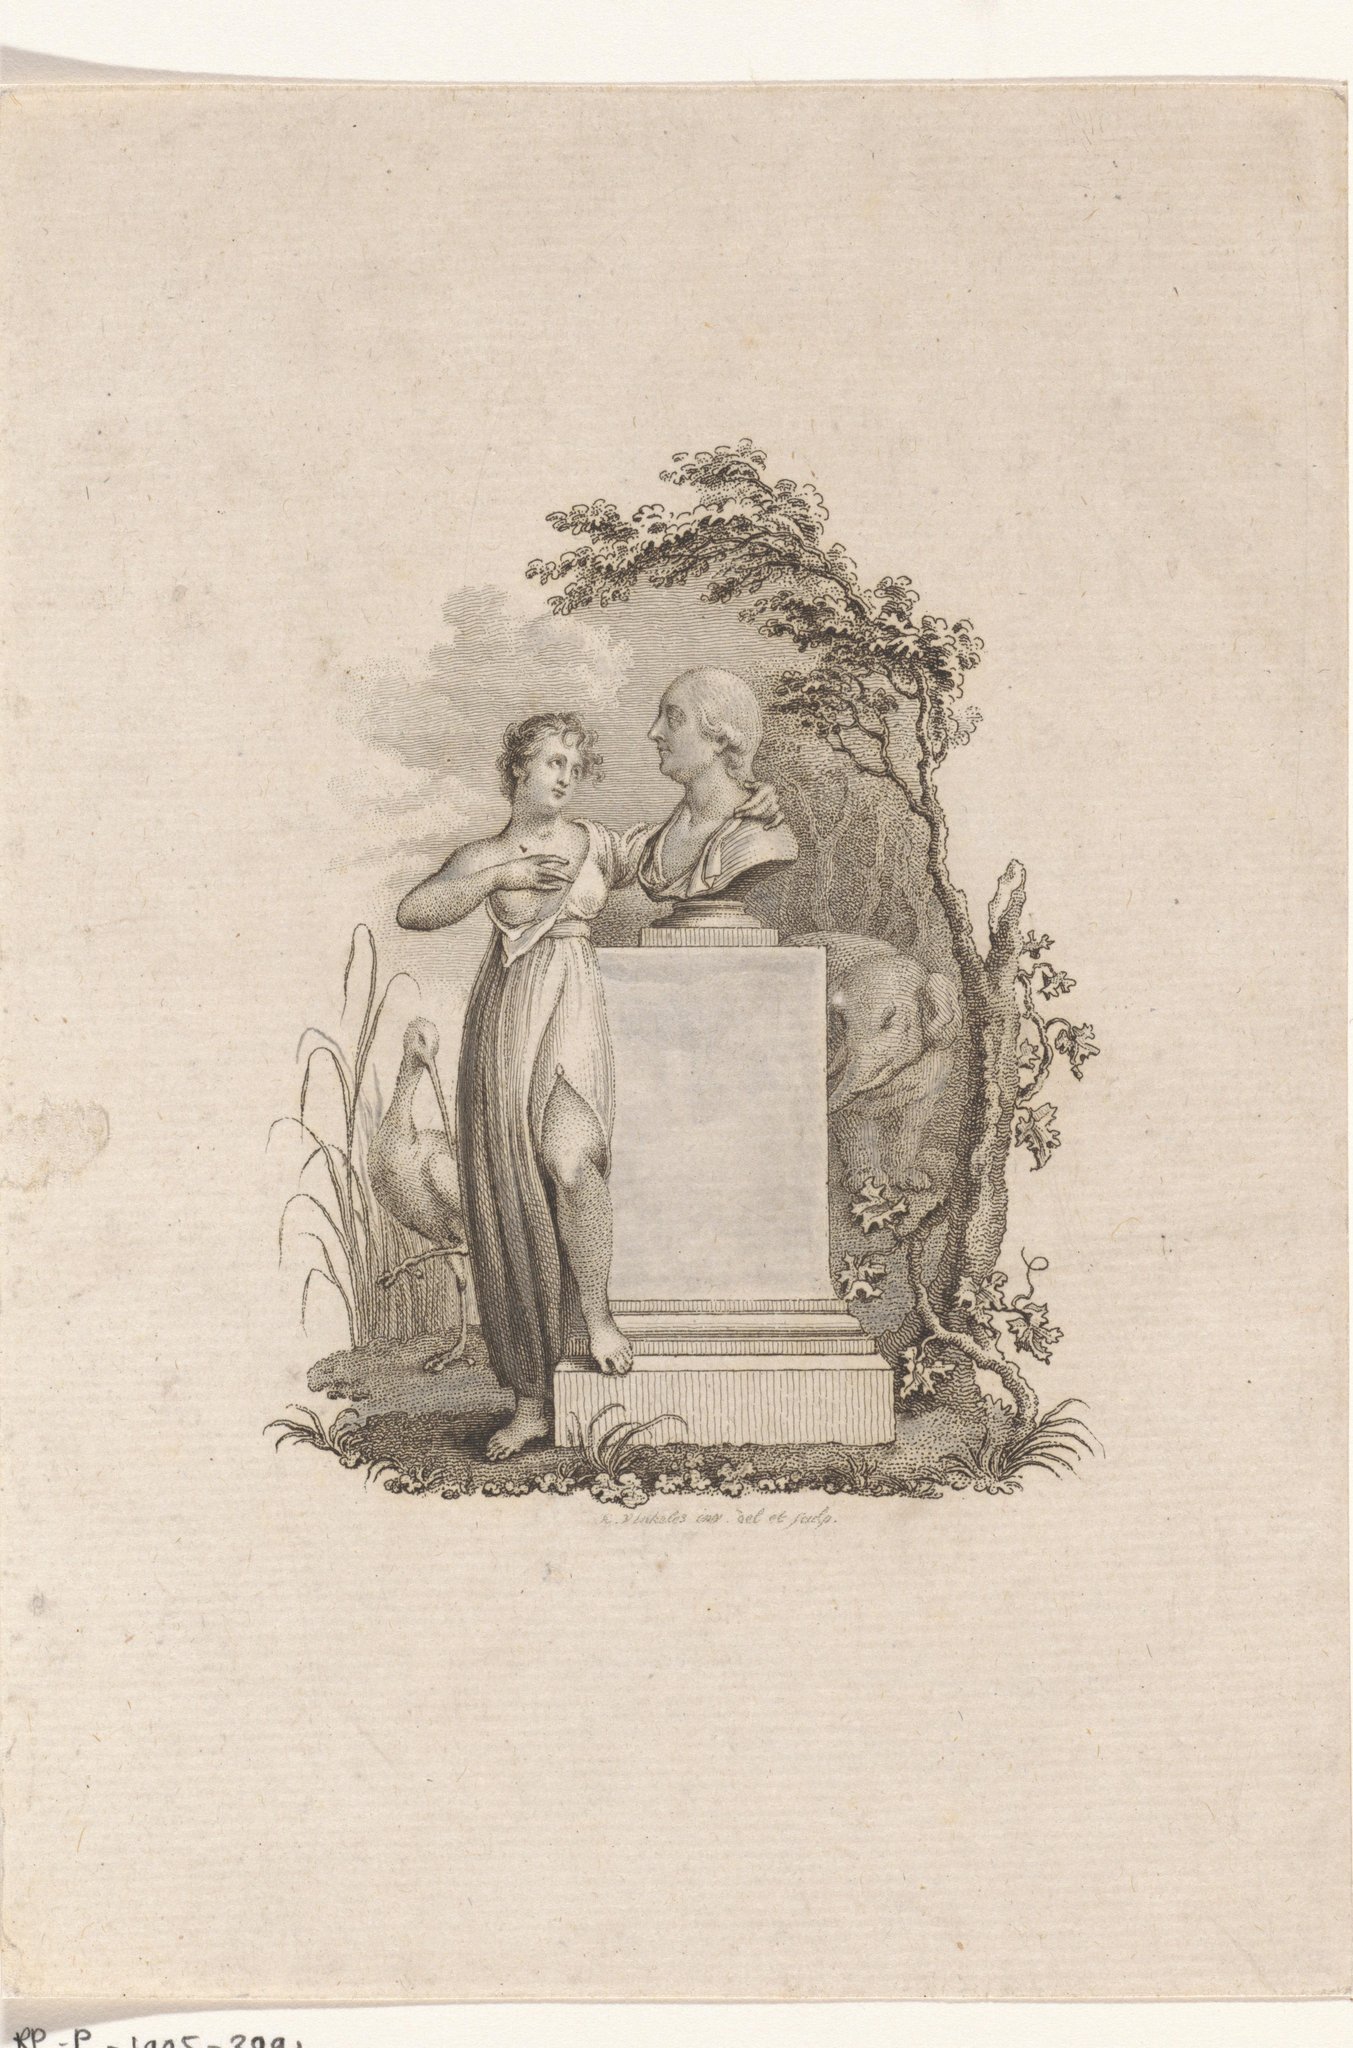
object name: print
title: Vrouw bij een buste van Jan Hendrik van Kinsbergen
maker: reinier vinkeles (i)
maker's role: draughtsman, print maker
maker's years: 1741-1816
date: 1781-1816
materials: paint, paper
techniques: brush, etching, pen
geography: amsterdam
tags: jonkheer jan hendrik van kinsbergen, statues, sculptures in garden, trunked animals: elephant, water-birds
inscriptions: collector's mark: Lugt 2228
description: Een vrouwenfiguur in een klassiek gewaad bij een buste van Jan Hendrik van Kinsbergen op een sokkel. Op de achtergrond een olifant en een vogel.